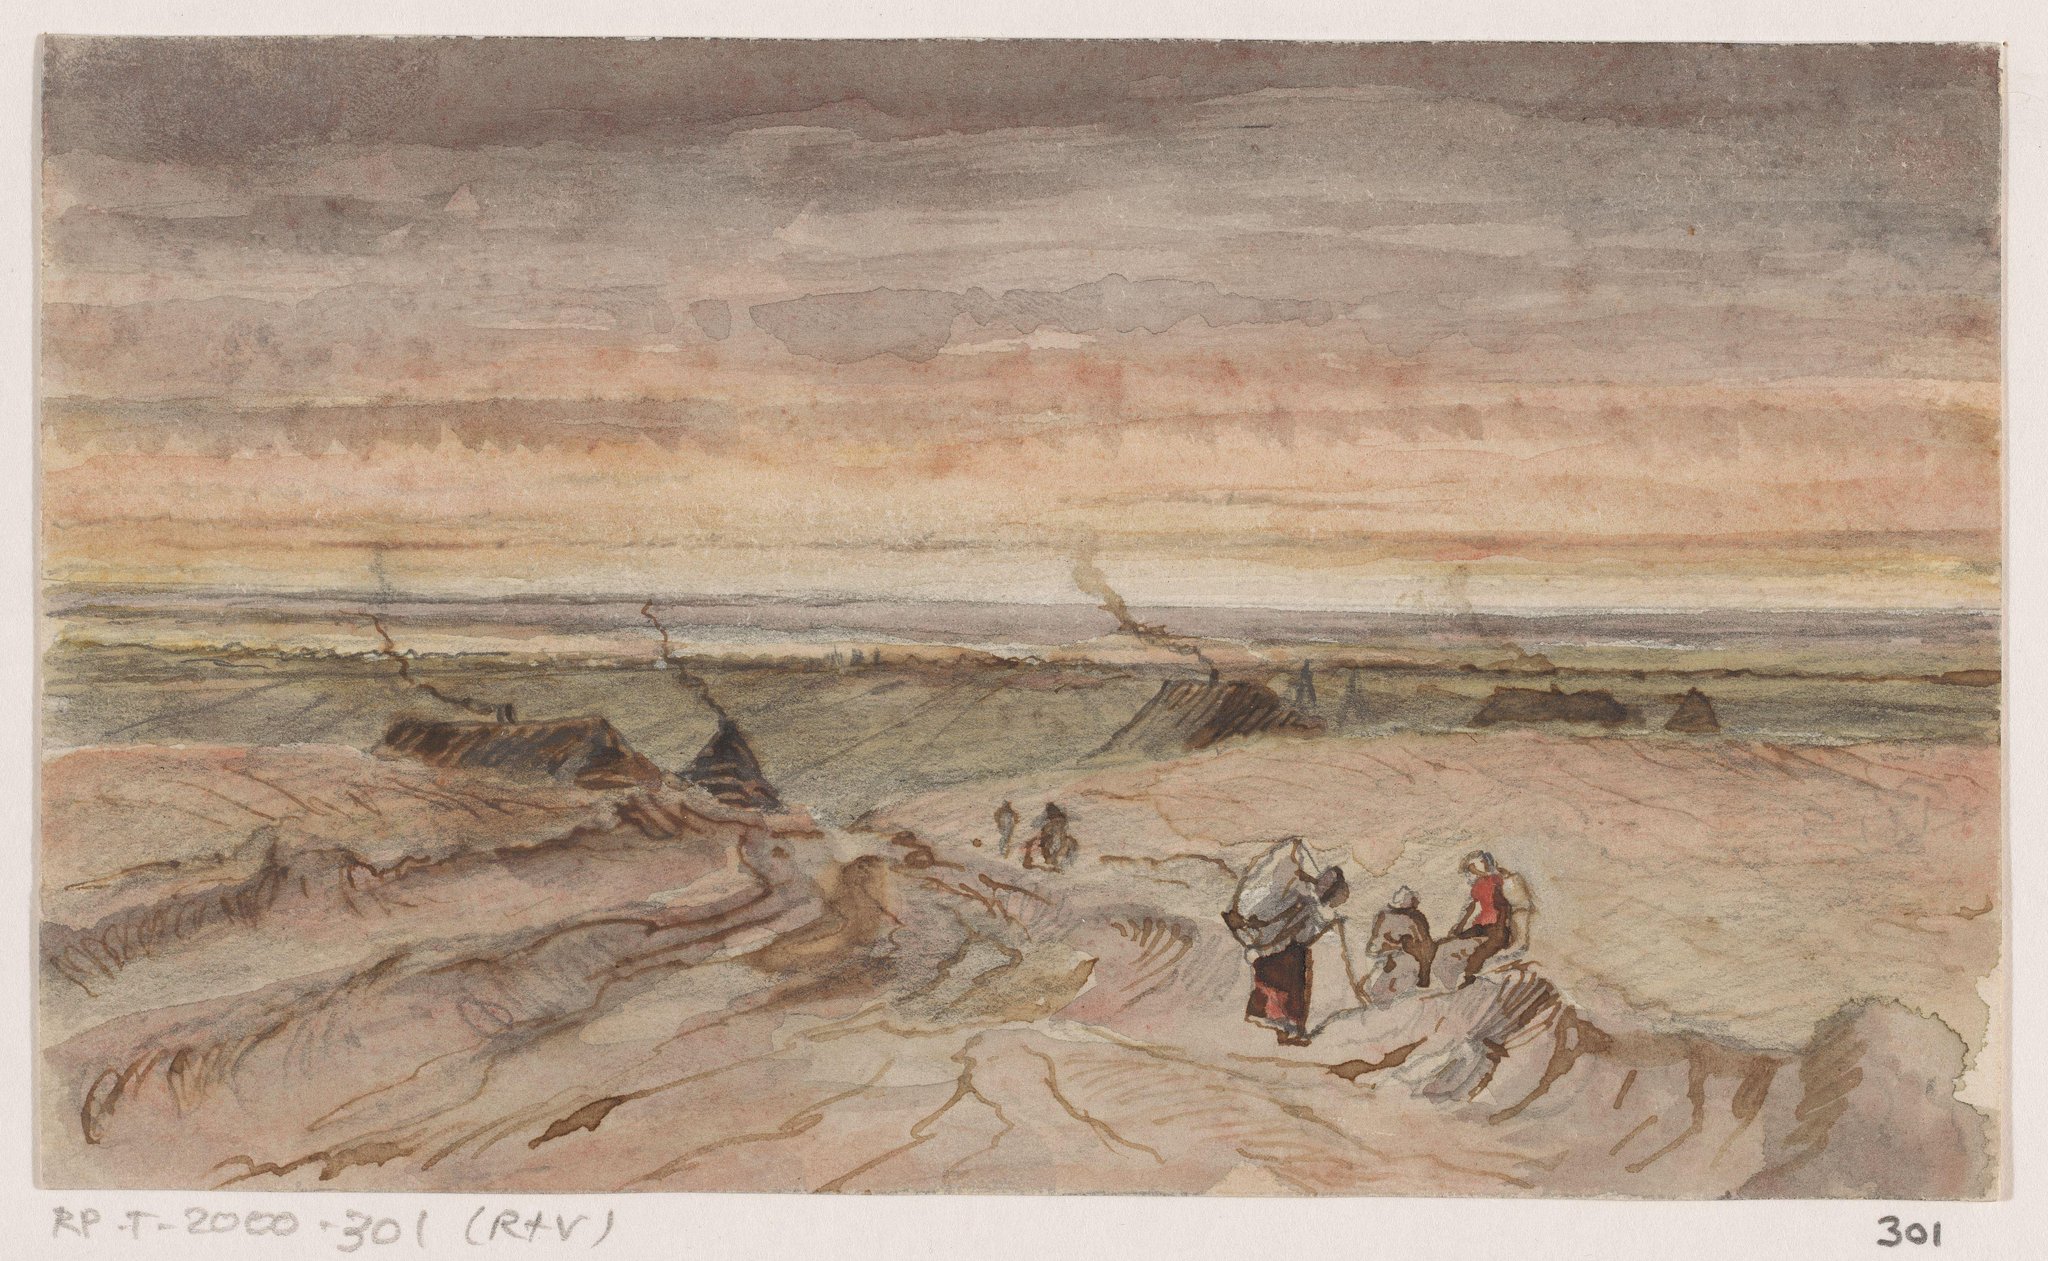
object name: drawing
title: Heide-Schets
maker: johannes tavenraat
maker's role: draughtsman, painter, print maker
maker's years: 1809-1881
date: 1840-1880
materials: ink, paper, watercolor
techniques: brush, pen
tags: village (+ city(-scape) with figures, staffage)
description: Gezicht op een dorp op de heide met enkele personen op de weg en rokende huizen.